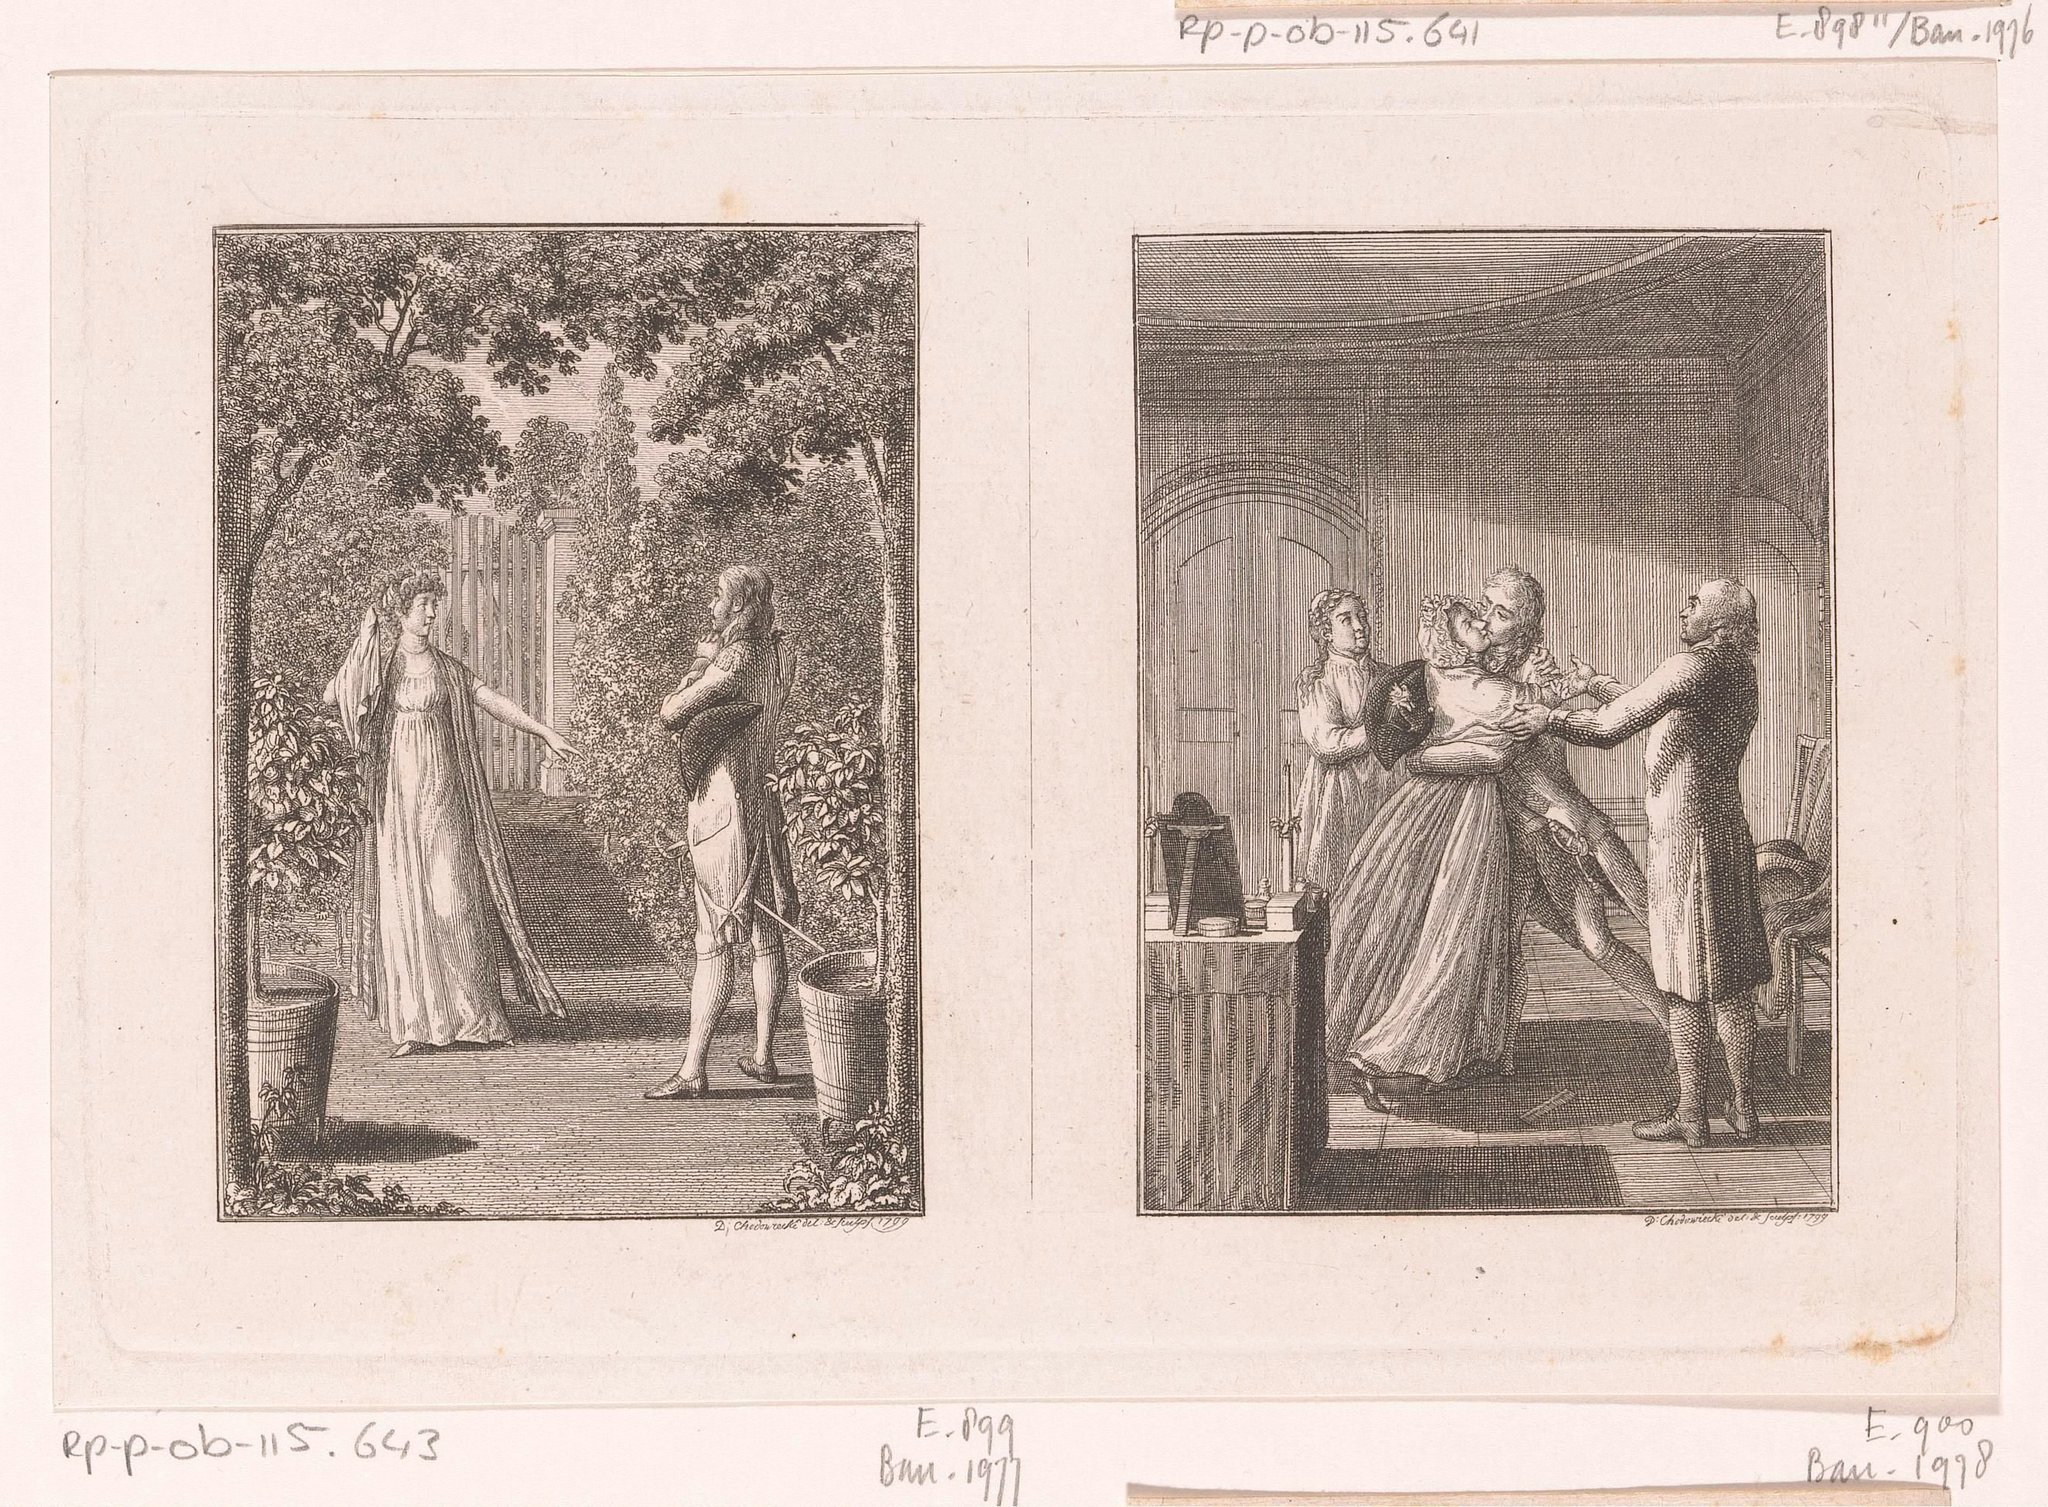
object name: print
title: Twee voorstellingen uit de verhalen van Karl Lang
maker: daniel nikolaus chodowiecki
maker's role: draughtsman, print maker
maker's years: 1726-1801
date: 1799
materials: paper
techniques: etching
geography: berlin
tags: (lovers) embracing each other, 'symplegma', garden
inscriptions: collector's mark: Lugt 2228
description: Prent gebruikt voor: Lang, Karl. Almanach und Taschenbuch für Häusliche und Gesellschaftliche Freuden (...). Heilbronn: Industrie Comtoir, 1799.